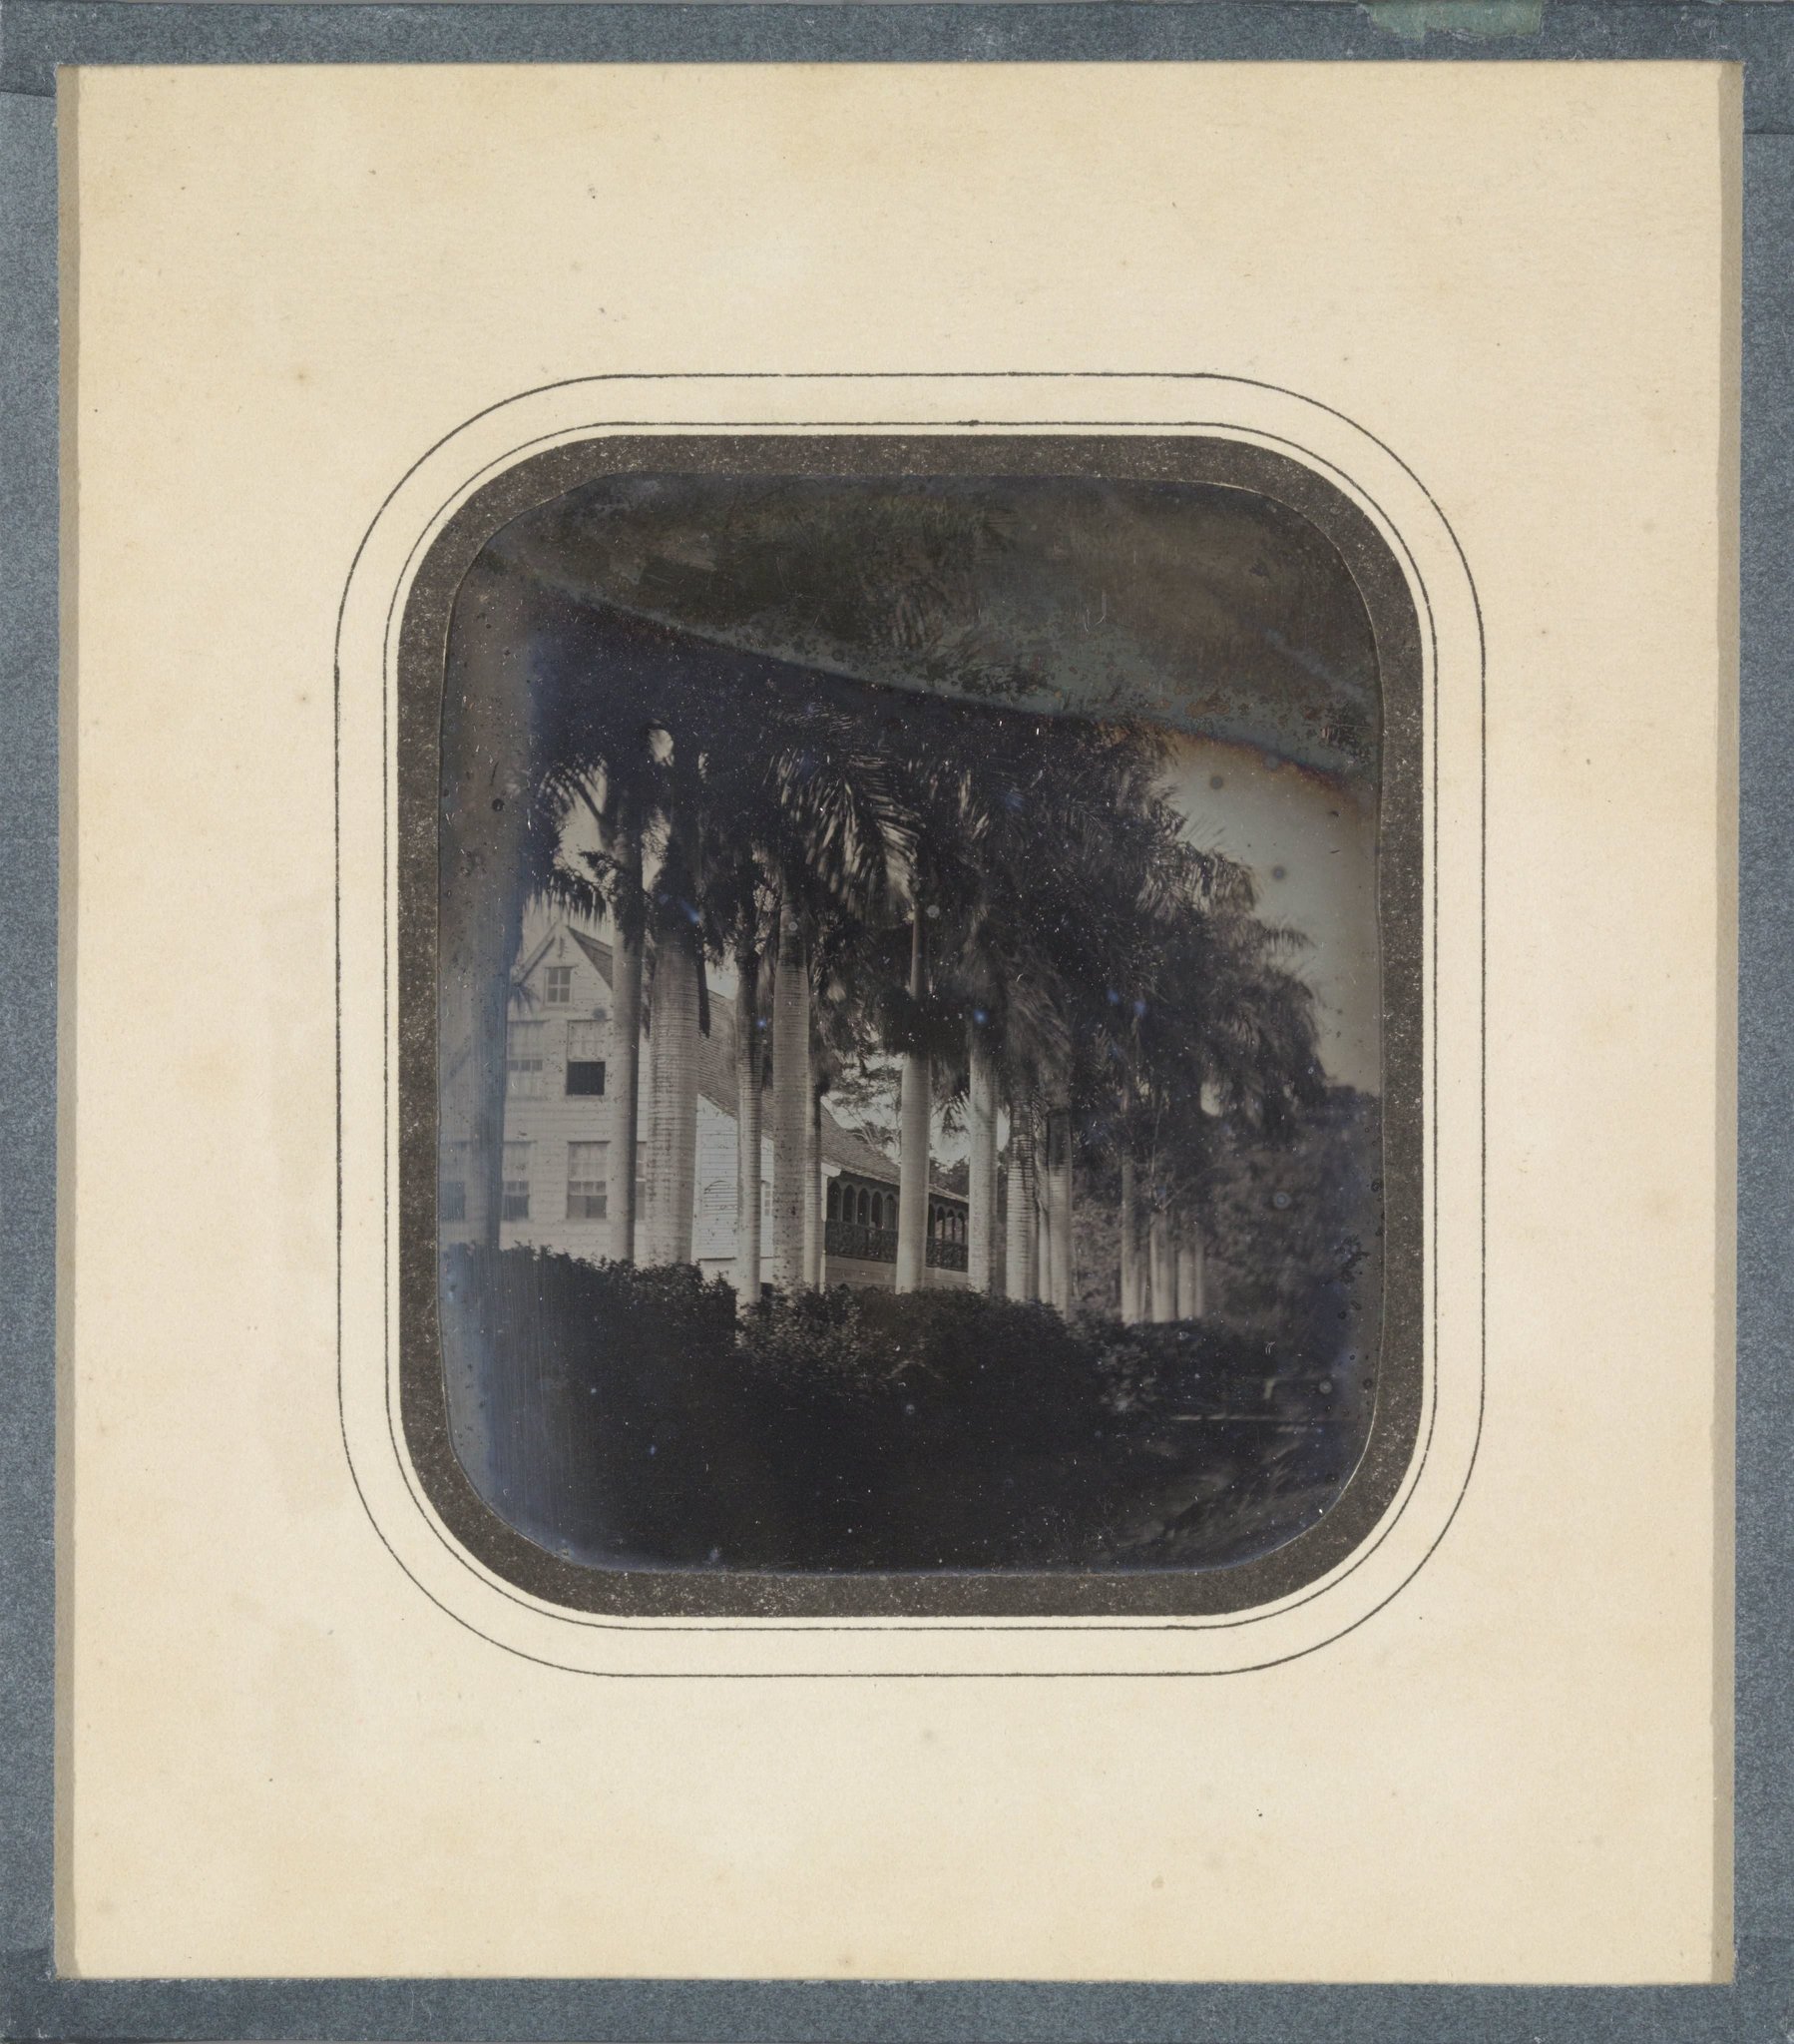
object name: photograph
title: Gezigt van het Buiten van F.L. Pichot, in de voorstad Zeelandia, Suriname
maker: Anonymous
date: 1845-1850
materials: copper, glass, paper, silver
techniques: daguerreotype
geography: paramaribo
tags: paramaribo (stad)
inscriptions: inscription: ‘Gezigt van het Buiten van F. L. Pichot, te Suriname groot een morgenlands - genomen van de Noord-zijde -- Eerste huis aan de Voorstad Zeelandia - NB de Voorstad Zeelandia is geheel Tuinstad, een uur gaans in den omtrek, met circa 80 huizen en tuinen’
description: Gezicht op het buitenhuis van F.L. Pichot van de Noordzijde, Zeelandia, Suriname in vierkant passe-partout met afgeronde hoeken.